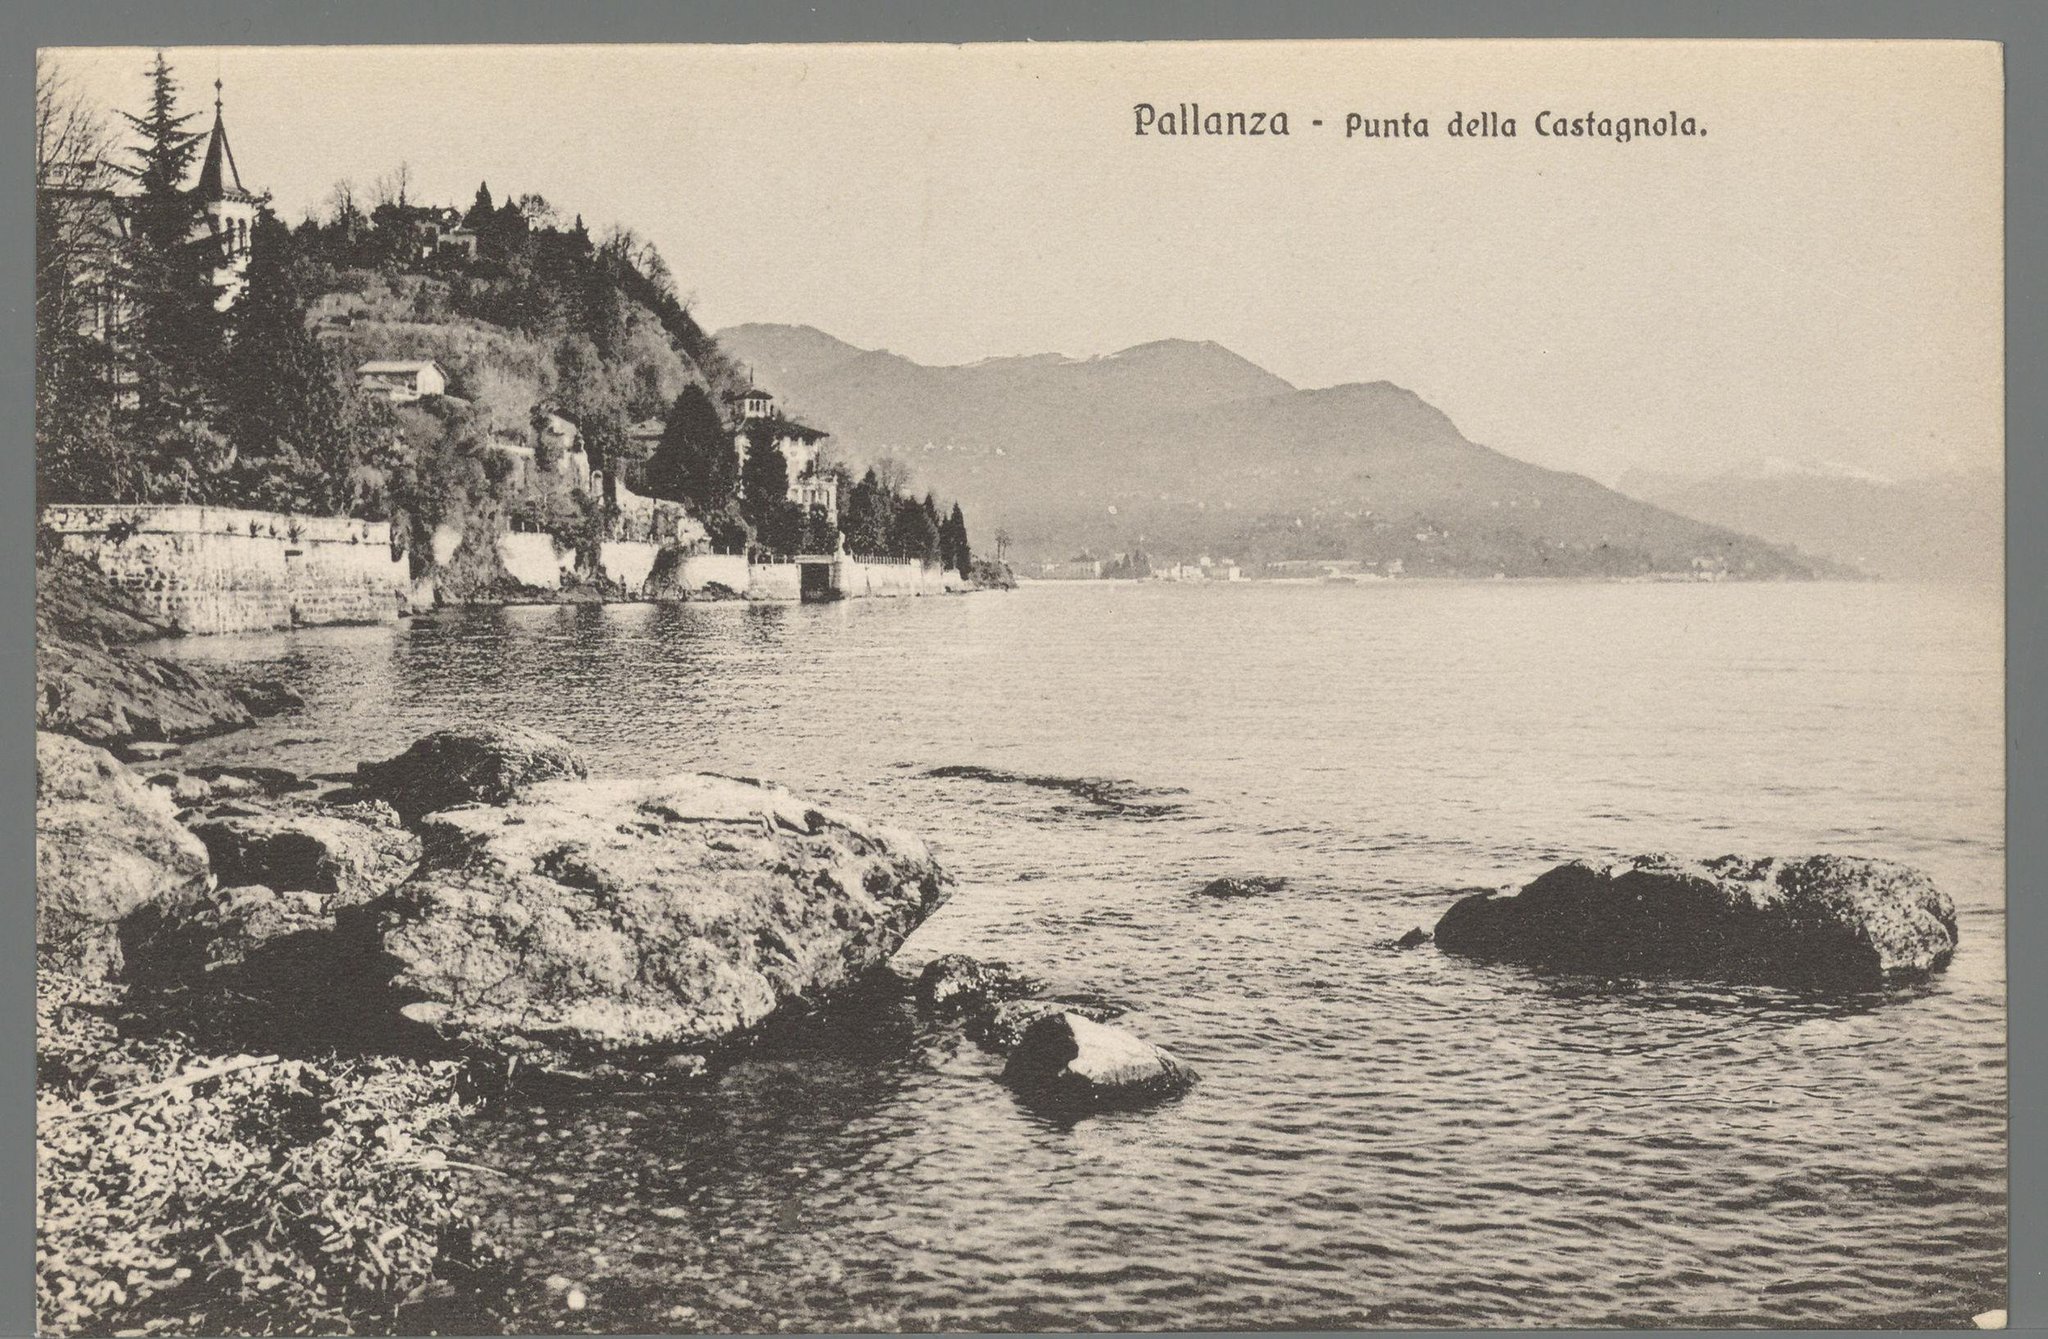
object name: photomechanical print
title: Pallanza. Punta della Castagnola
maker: Anonymous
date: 1906-1909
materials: cardboard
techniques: photograph, writing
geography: zurich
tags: rocky coast, lake